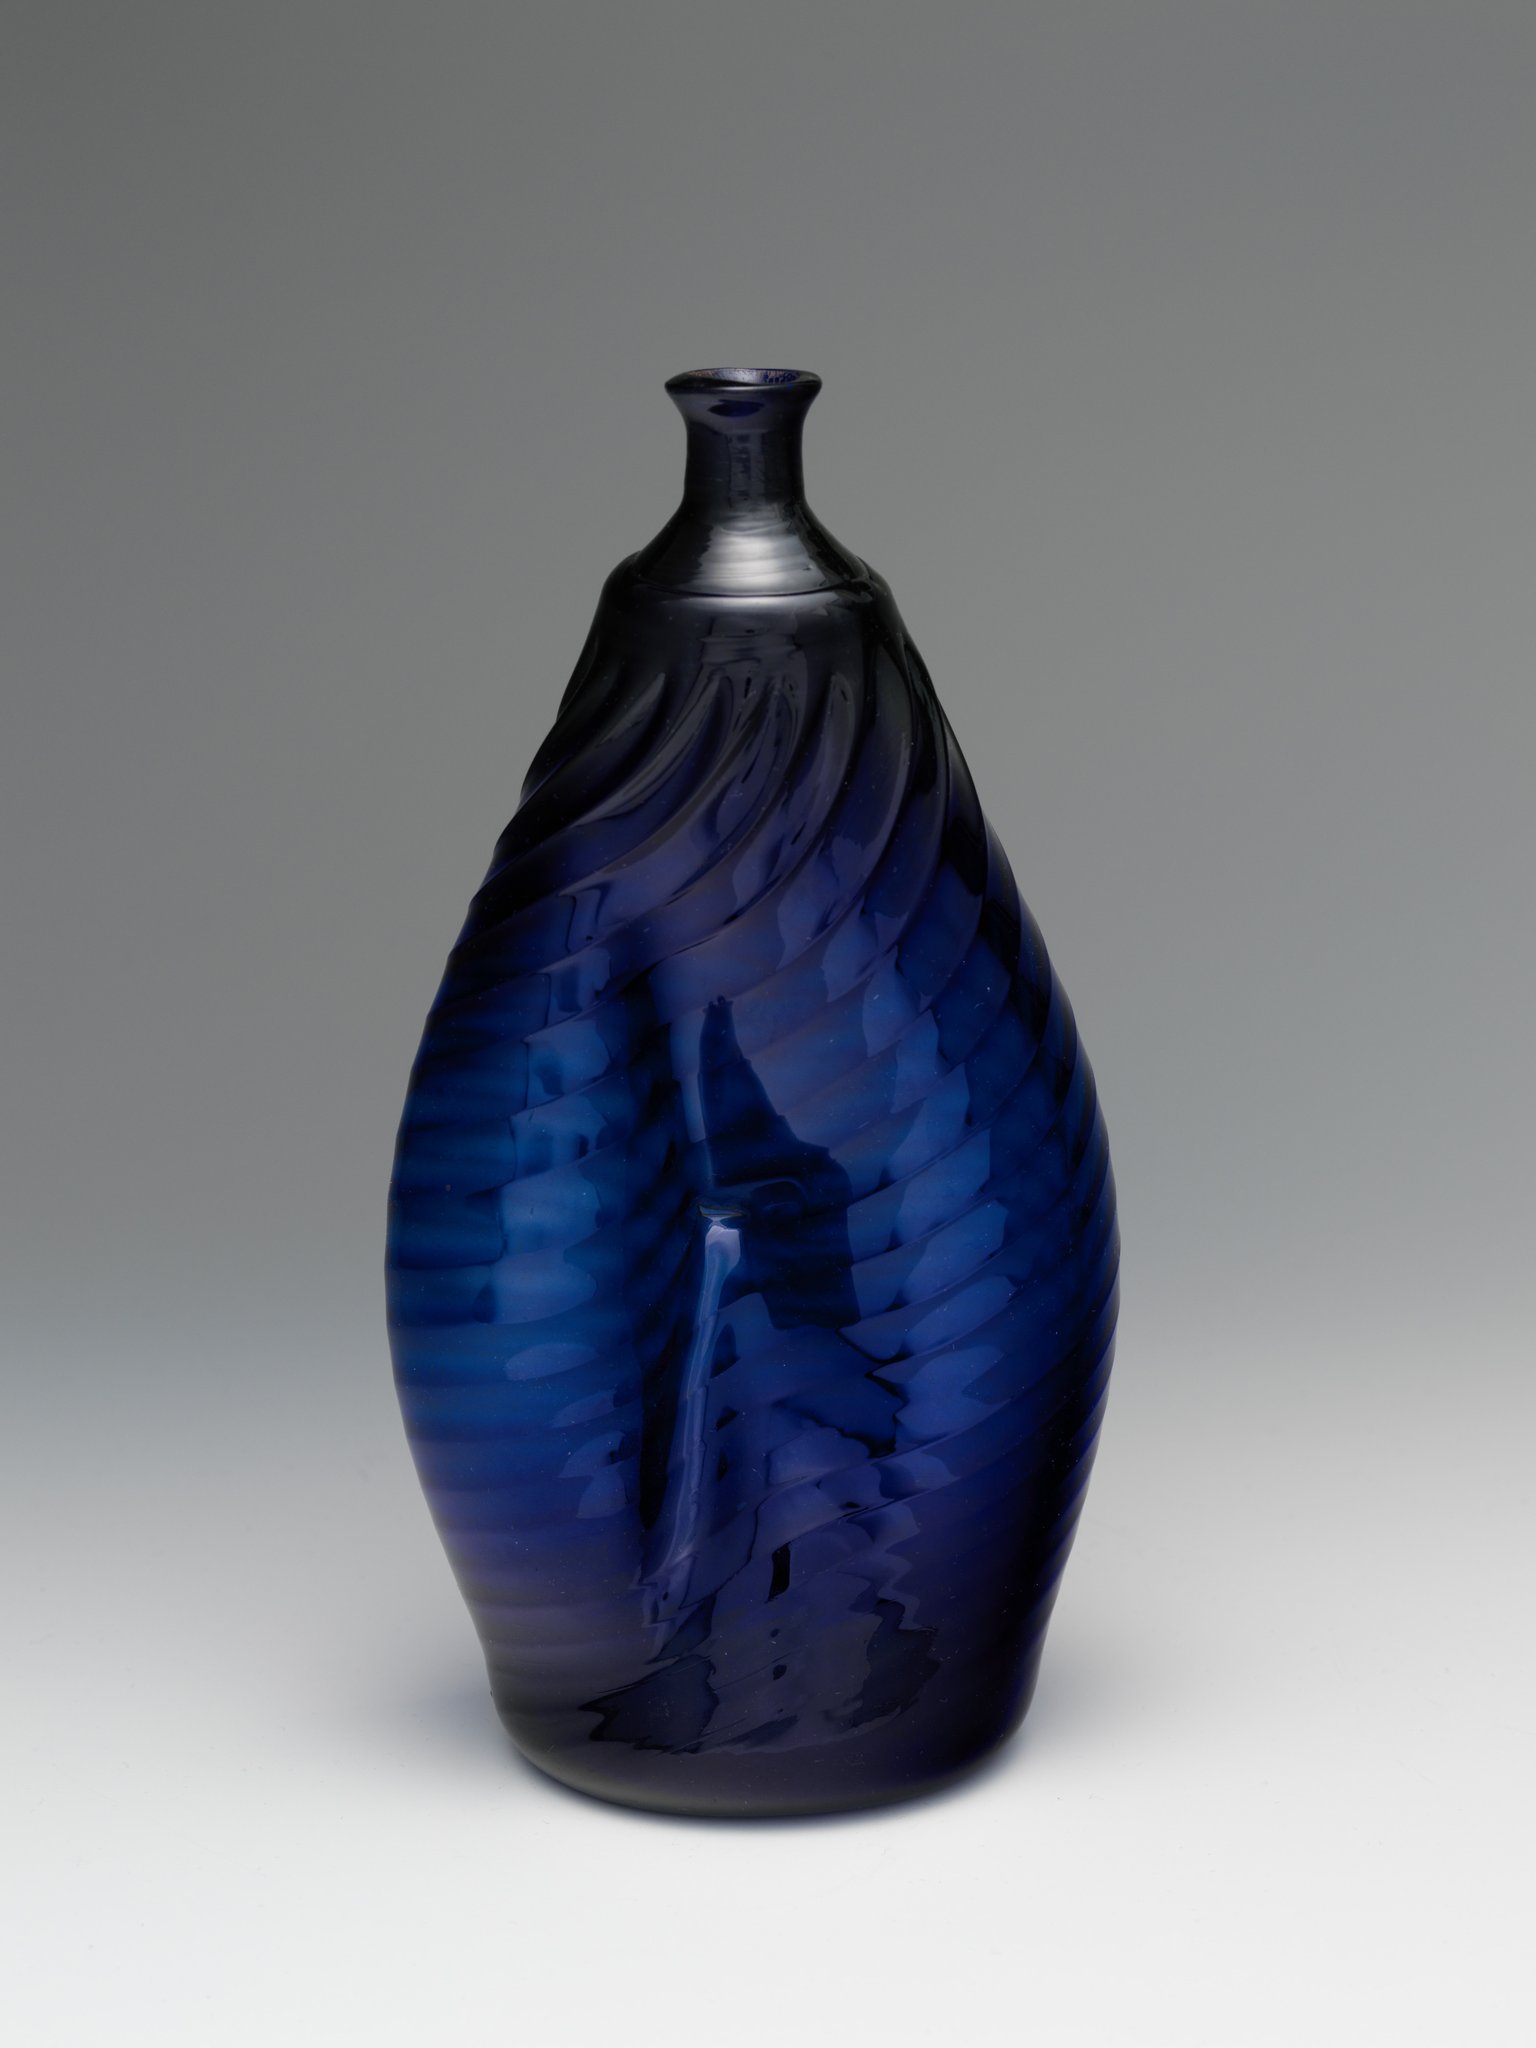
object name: bottle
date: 1701-1800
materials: glass